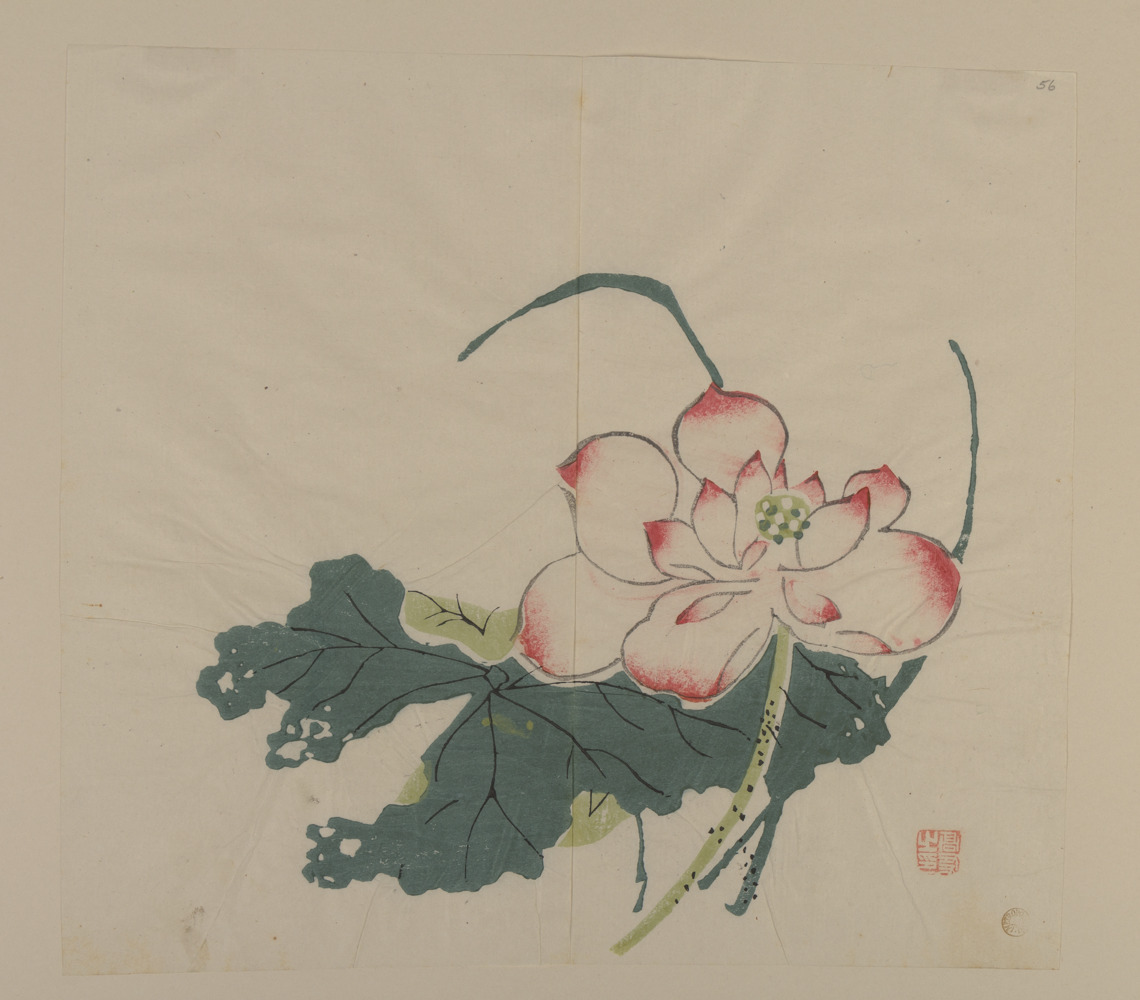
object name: print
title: Page from Shi Zhu Zhai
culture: chinese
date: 1736-1795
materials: ink, paper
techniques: polychrome, woodblock print